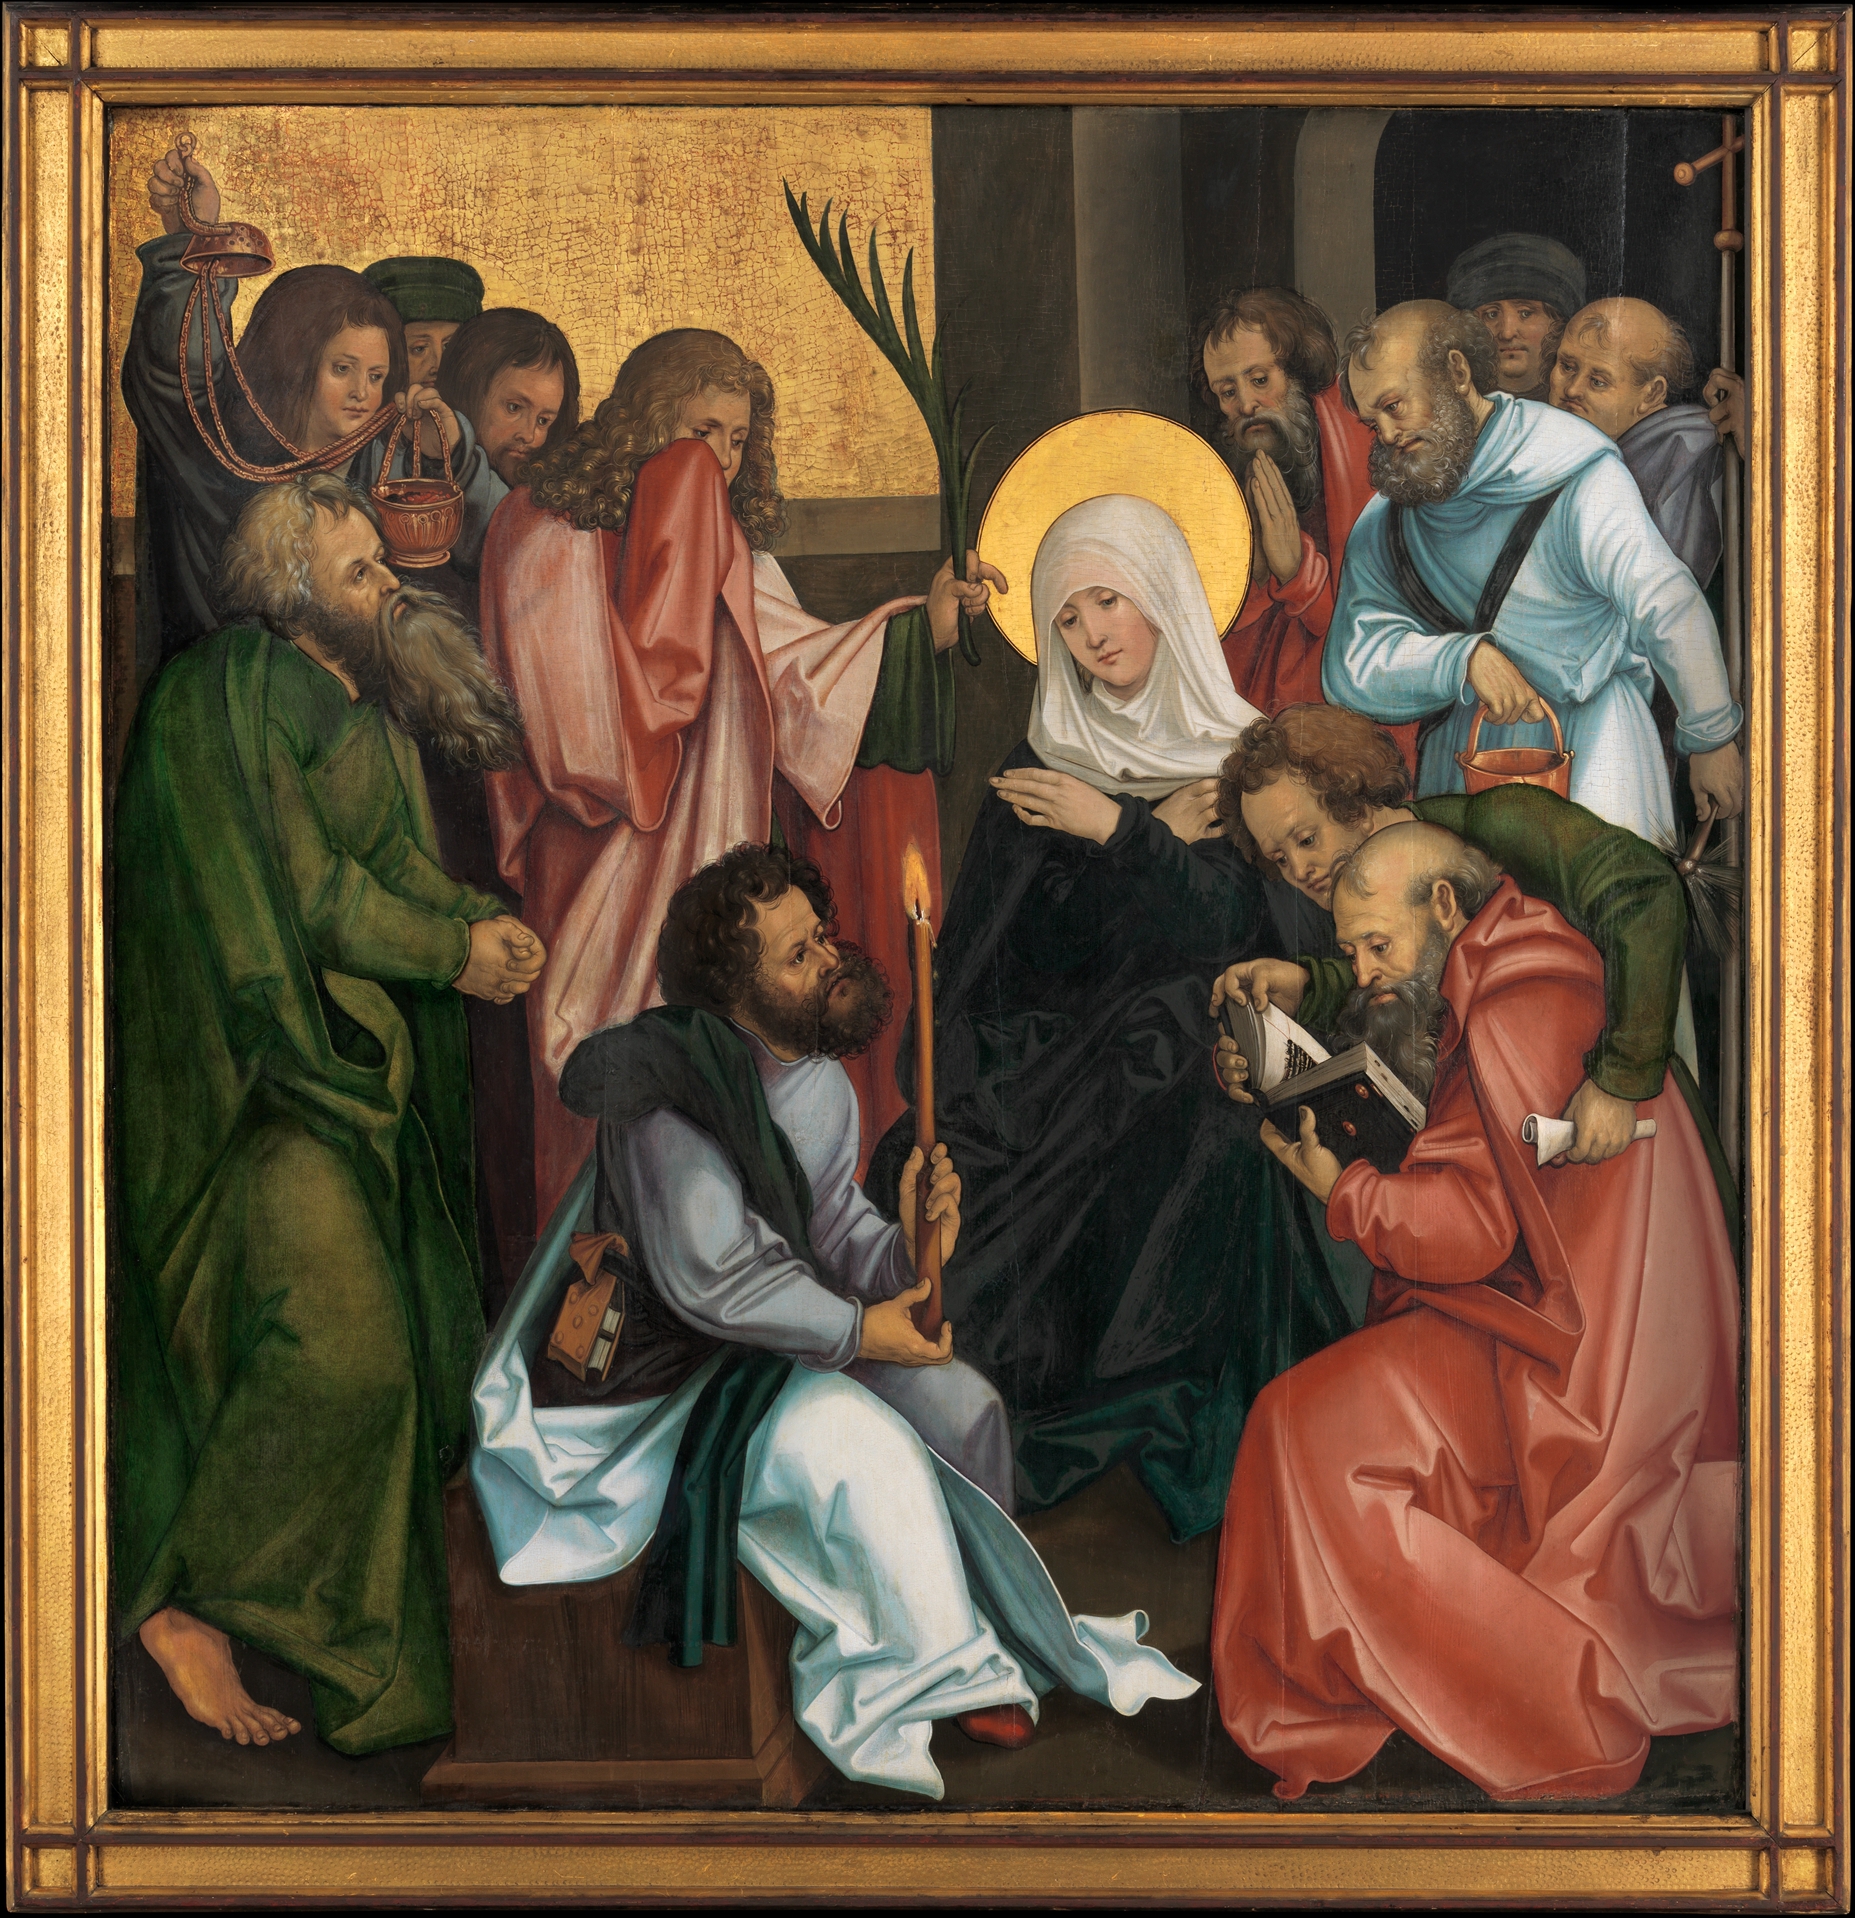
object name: painting, wing of an altarpiece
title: The Dormition of the Virgin; (reverse) Christ Carrying the Cross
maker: hans schäufelein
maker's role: artist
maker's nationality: german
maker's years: 1480-1540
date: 1510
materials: gold, oil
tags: reading,apostles,christ,virgin mary,bearing the cross,death of the virgin